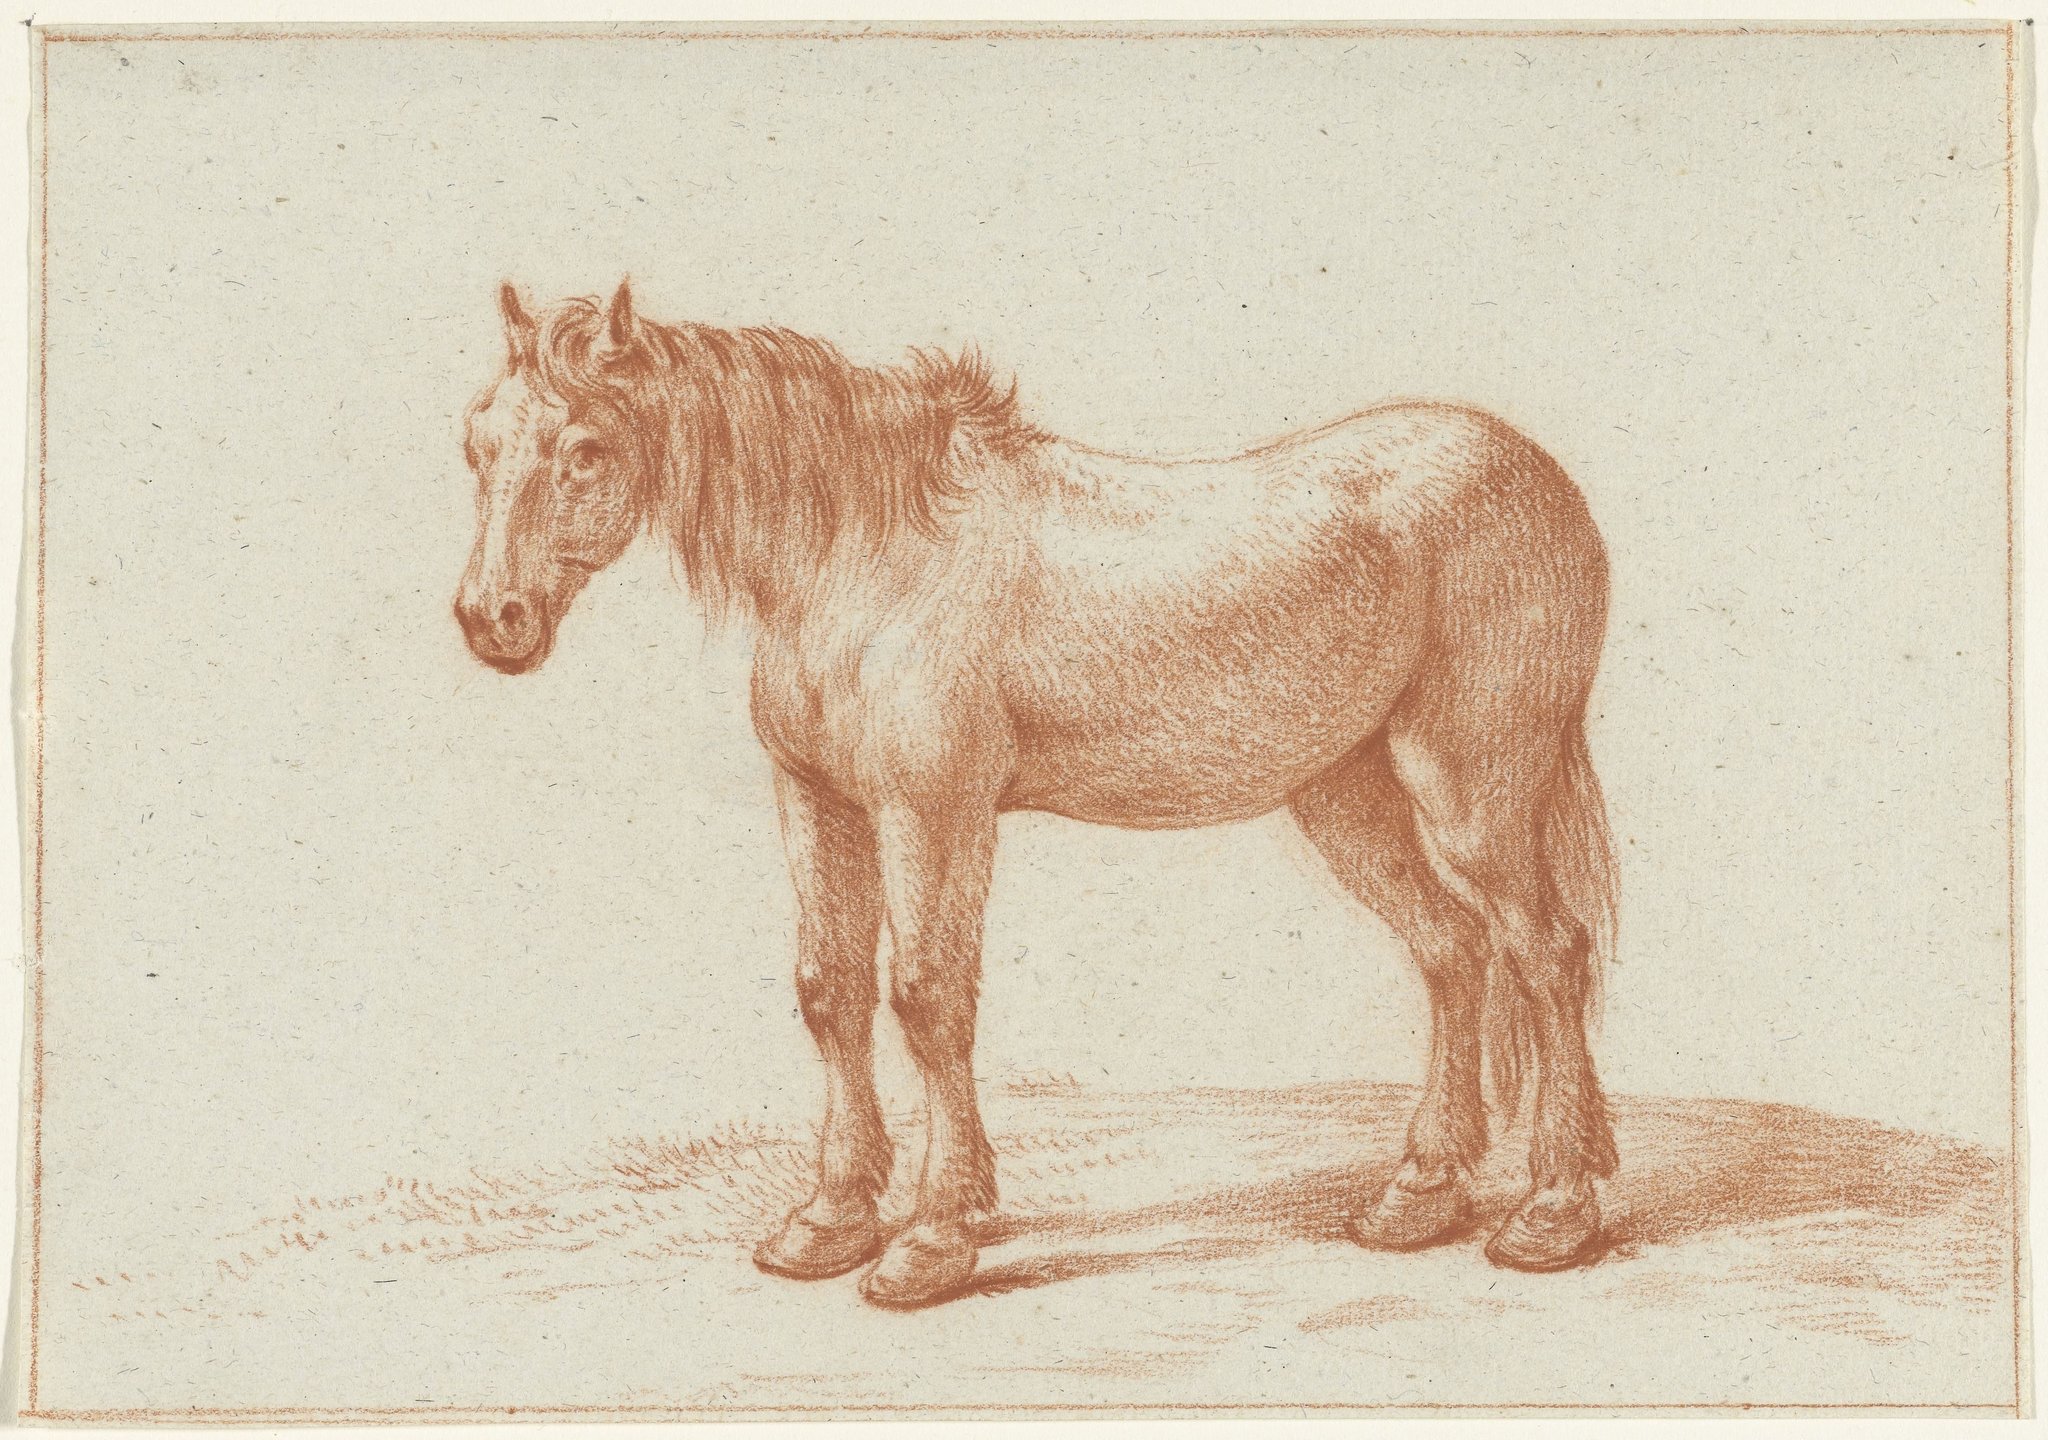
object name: drawing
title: Staand paard, naar links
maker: jean bernard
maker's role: draughtsman, print maker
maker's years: 1765-1833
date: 1775-1833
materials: chalk, paper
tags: horse